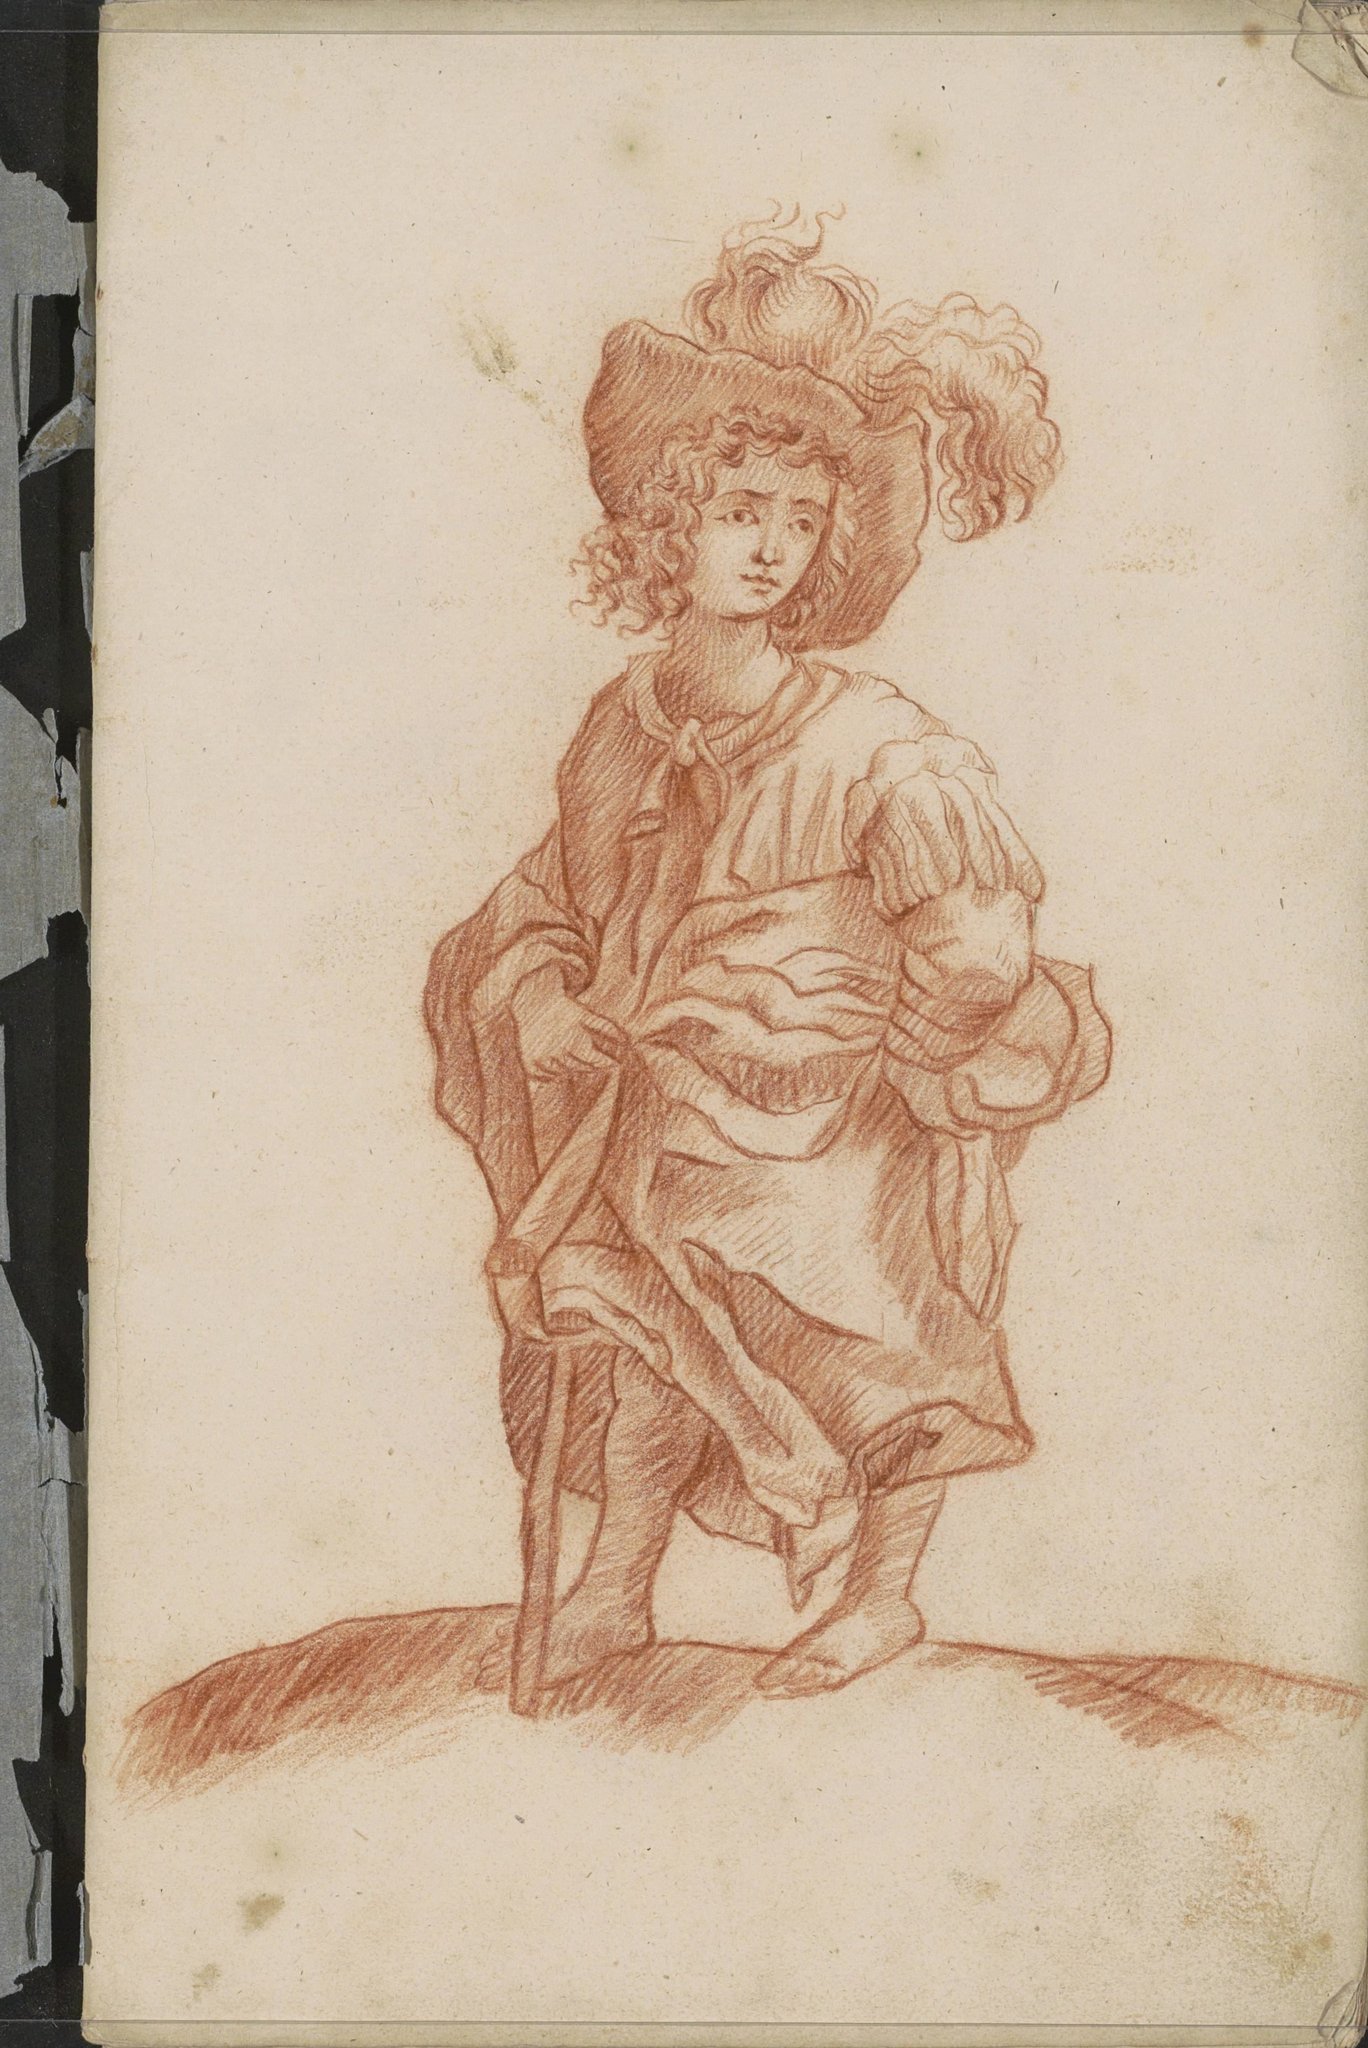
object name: sketchbook leaf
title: Jongen met een hoed met een veer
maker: hendrick van beaumont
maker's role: draughtsman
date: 1696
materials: chalk, paper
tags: boy (child between toddler and youth), head-gear: hat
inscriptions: number: ‘3’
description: Blad 1 recto uit een schetsboek met 30 bladen.